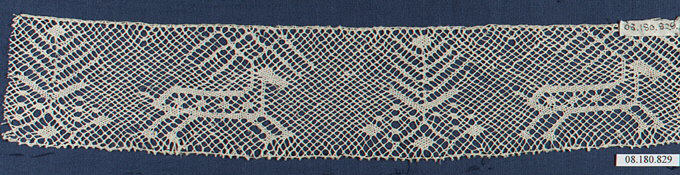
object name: fragment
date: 1701-1800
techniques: lace